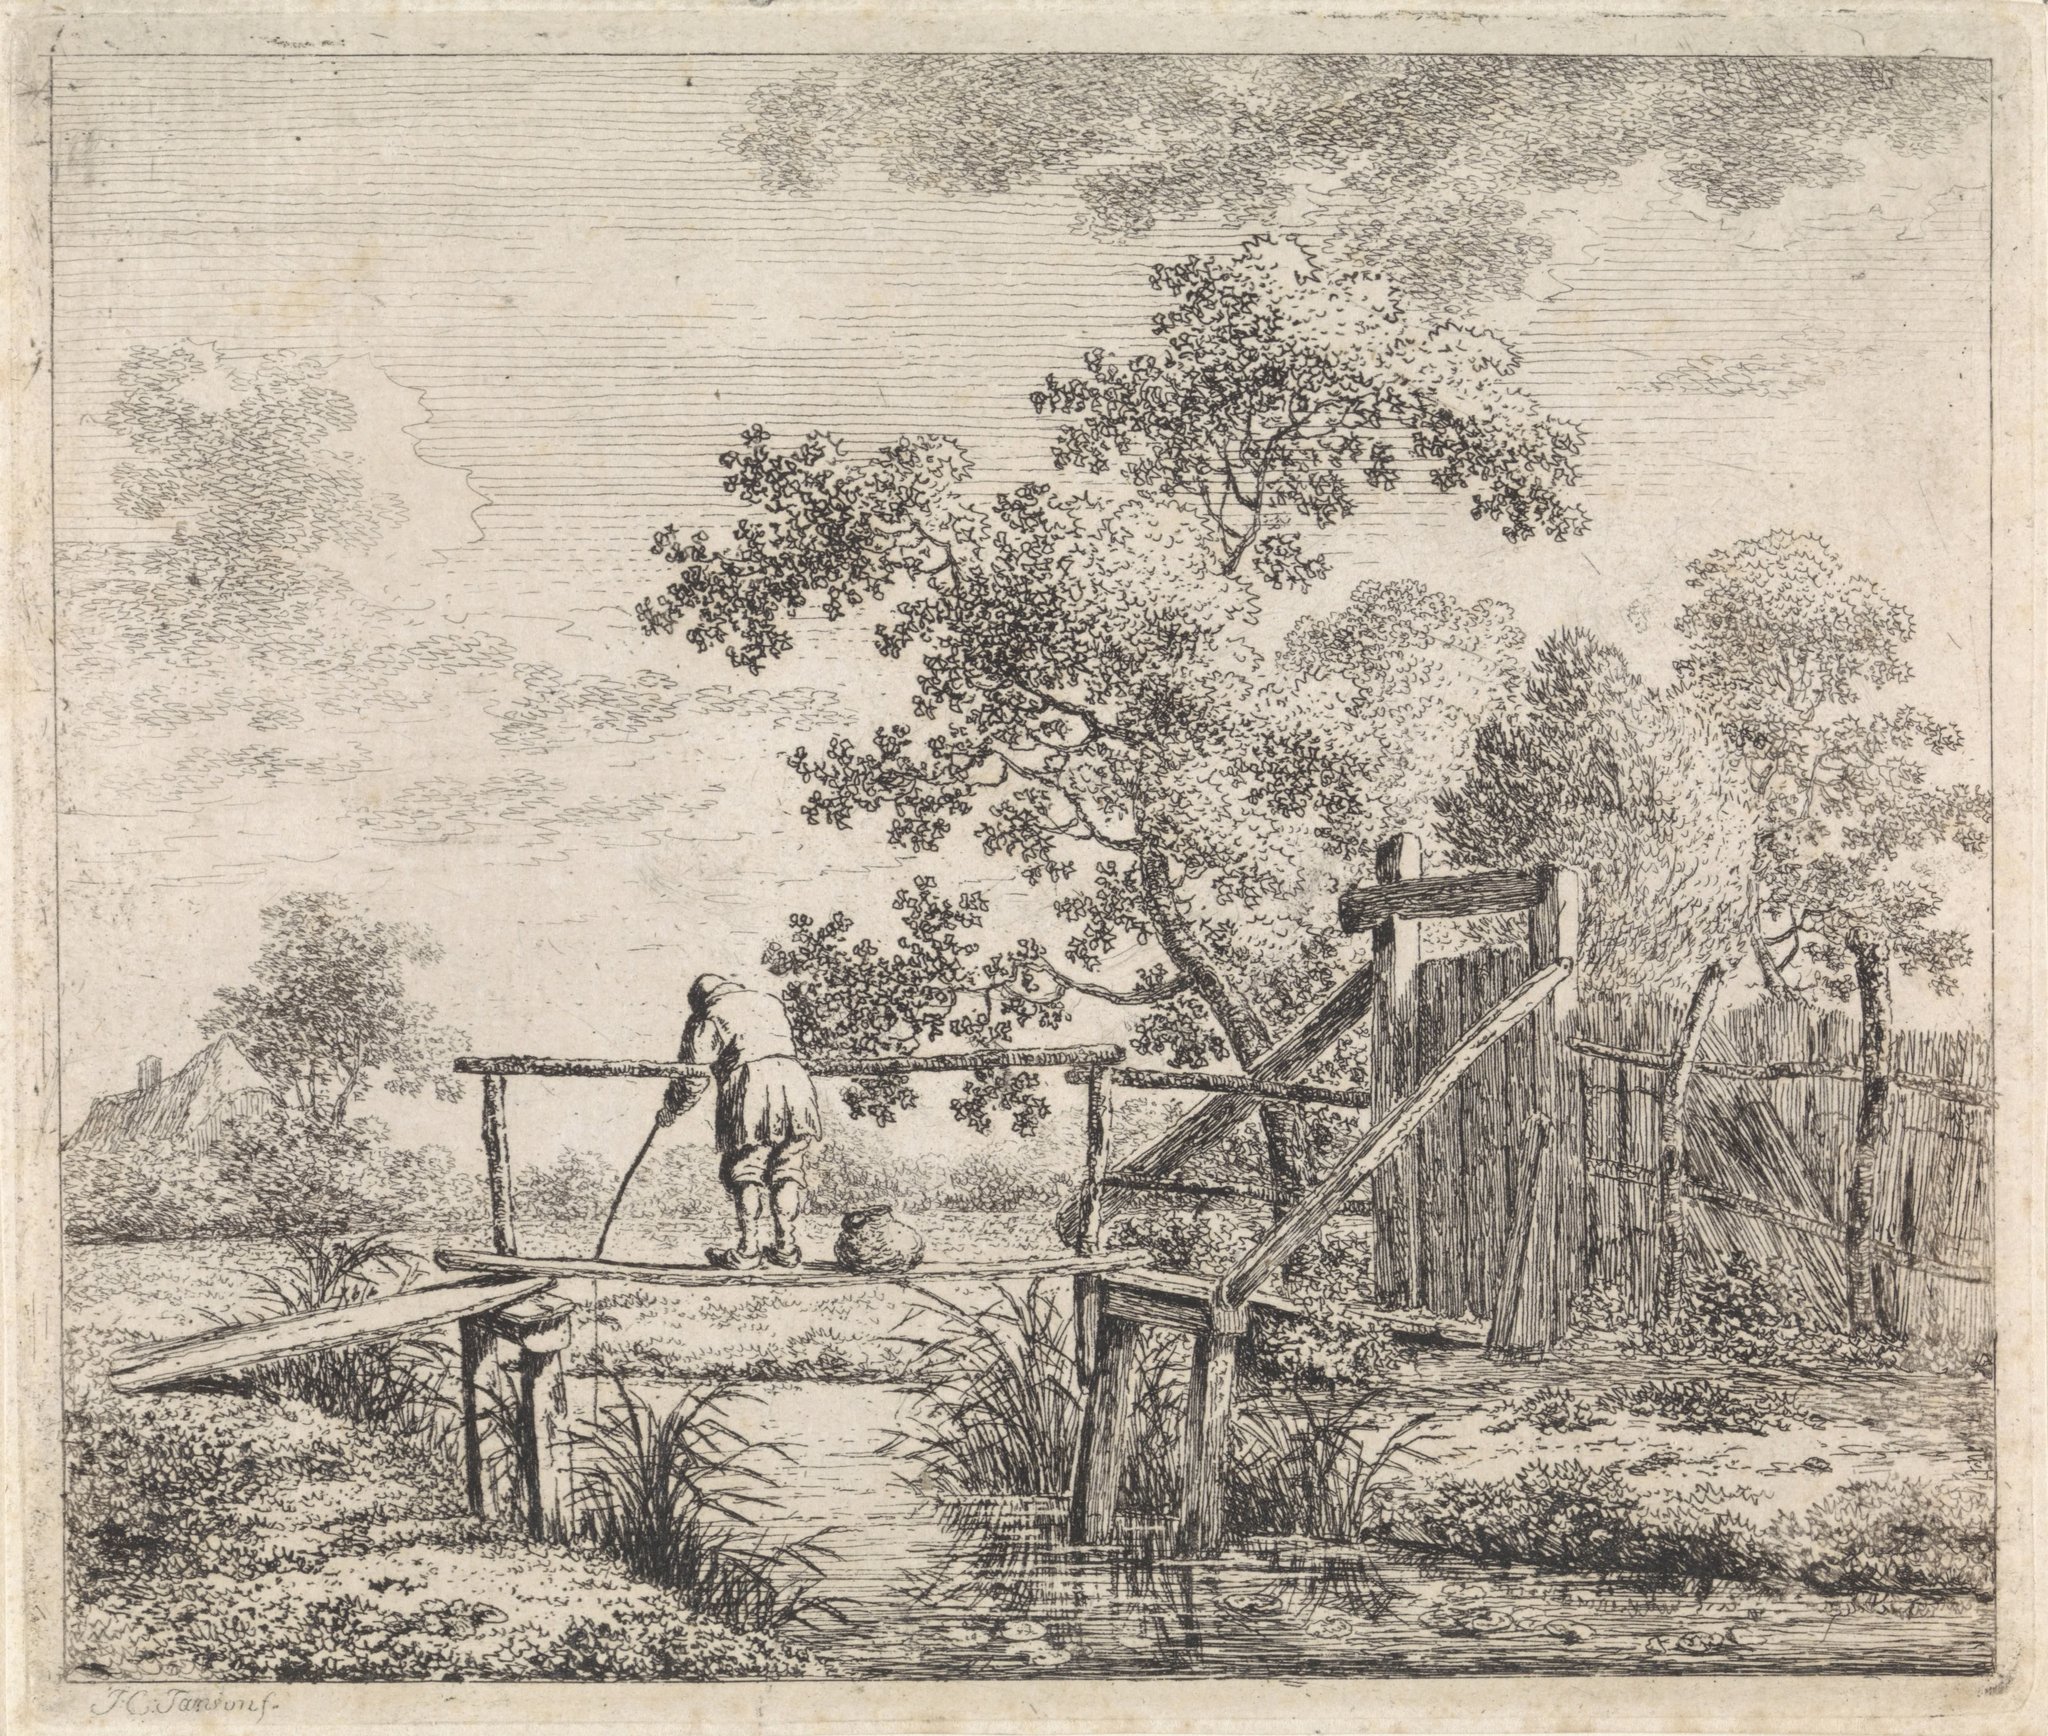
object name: print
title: Landschap met visser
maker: johannes christiaan janson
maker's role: draughtsman, painter, print maker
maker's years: 1763-1823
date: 1778-1823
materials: paper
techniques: etching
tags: fisherman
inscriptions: collector's mark: Lugt 2228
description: Landschap met visser op een houten brug, op de rug gezien. Naast hem staat zijn viskaar. Mét de lucht.